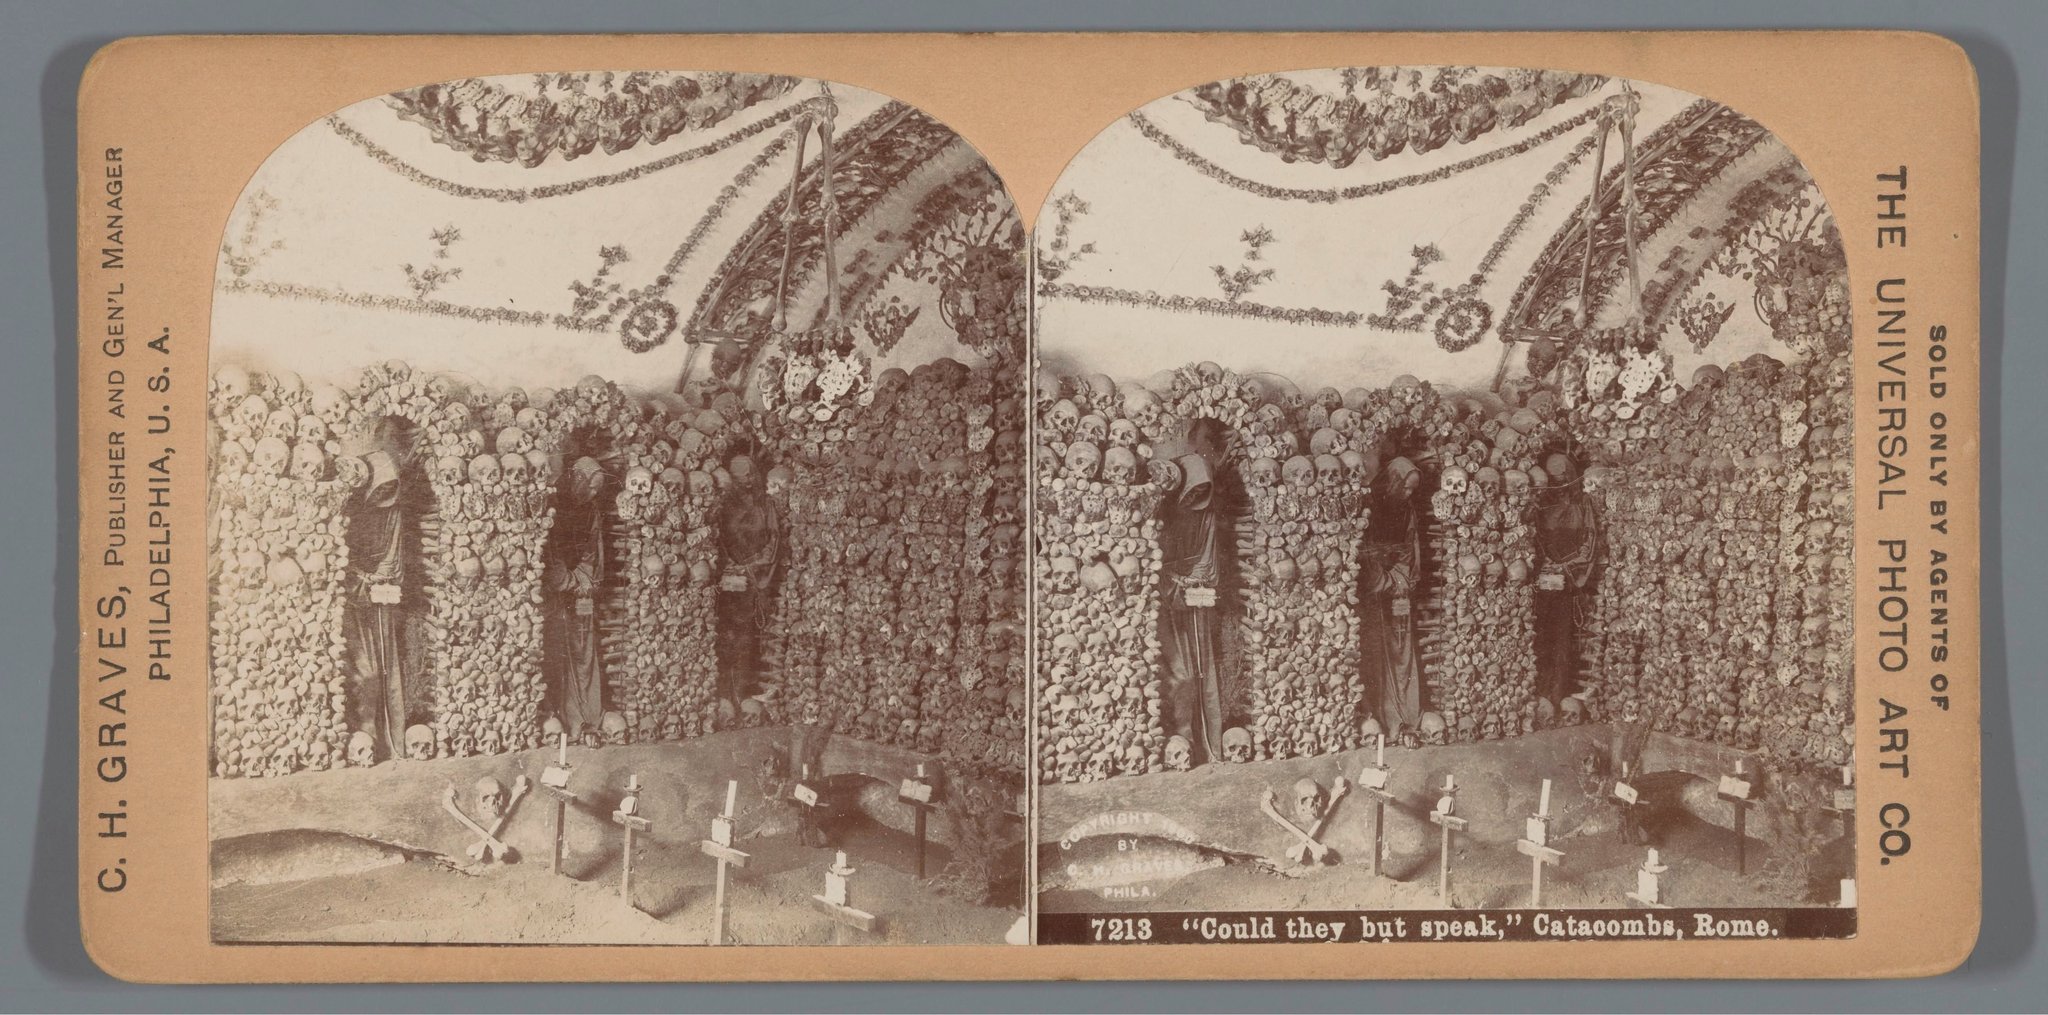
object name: stereograph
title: "Could they but speak", Catacombs, Rome.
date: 1900-1920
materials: cardboard, photographic support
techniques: daylight paper print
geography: santa maria della concezione dei cappuccini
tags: charnelhouse, ossuary, parts of church interior (crypt)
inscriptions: name: ‘SOLD ONLY BY AGENTS OF THE UNIVERSAL PHOTO ART CO.’, number: ‘7213’, number: ‘29’